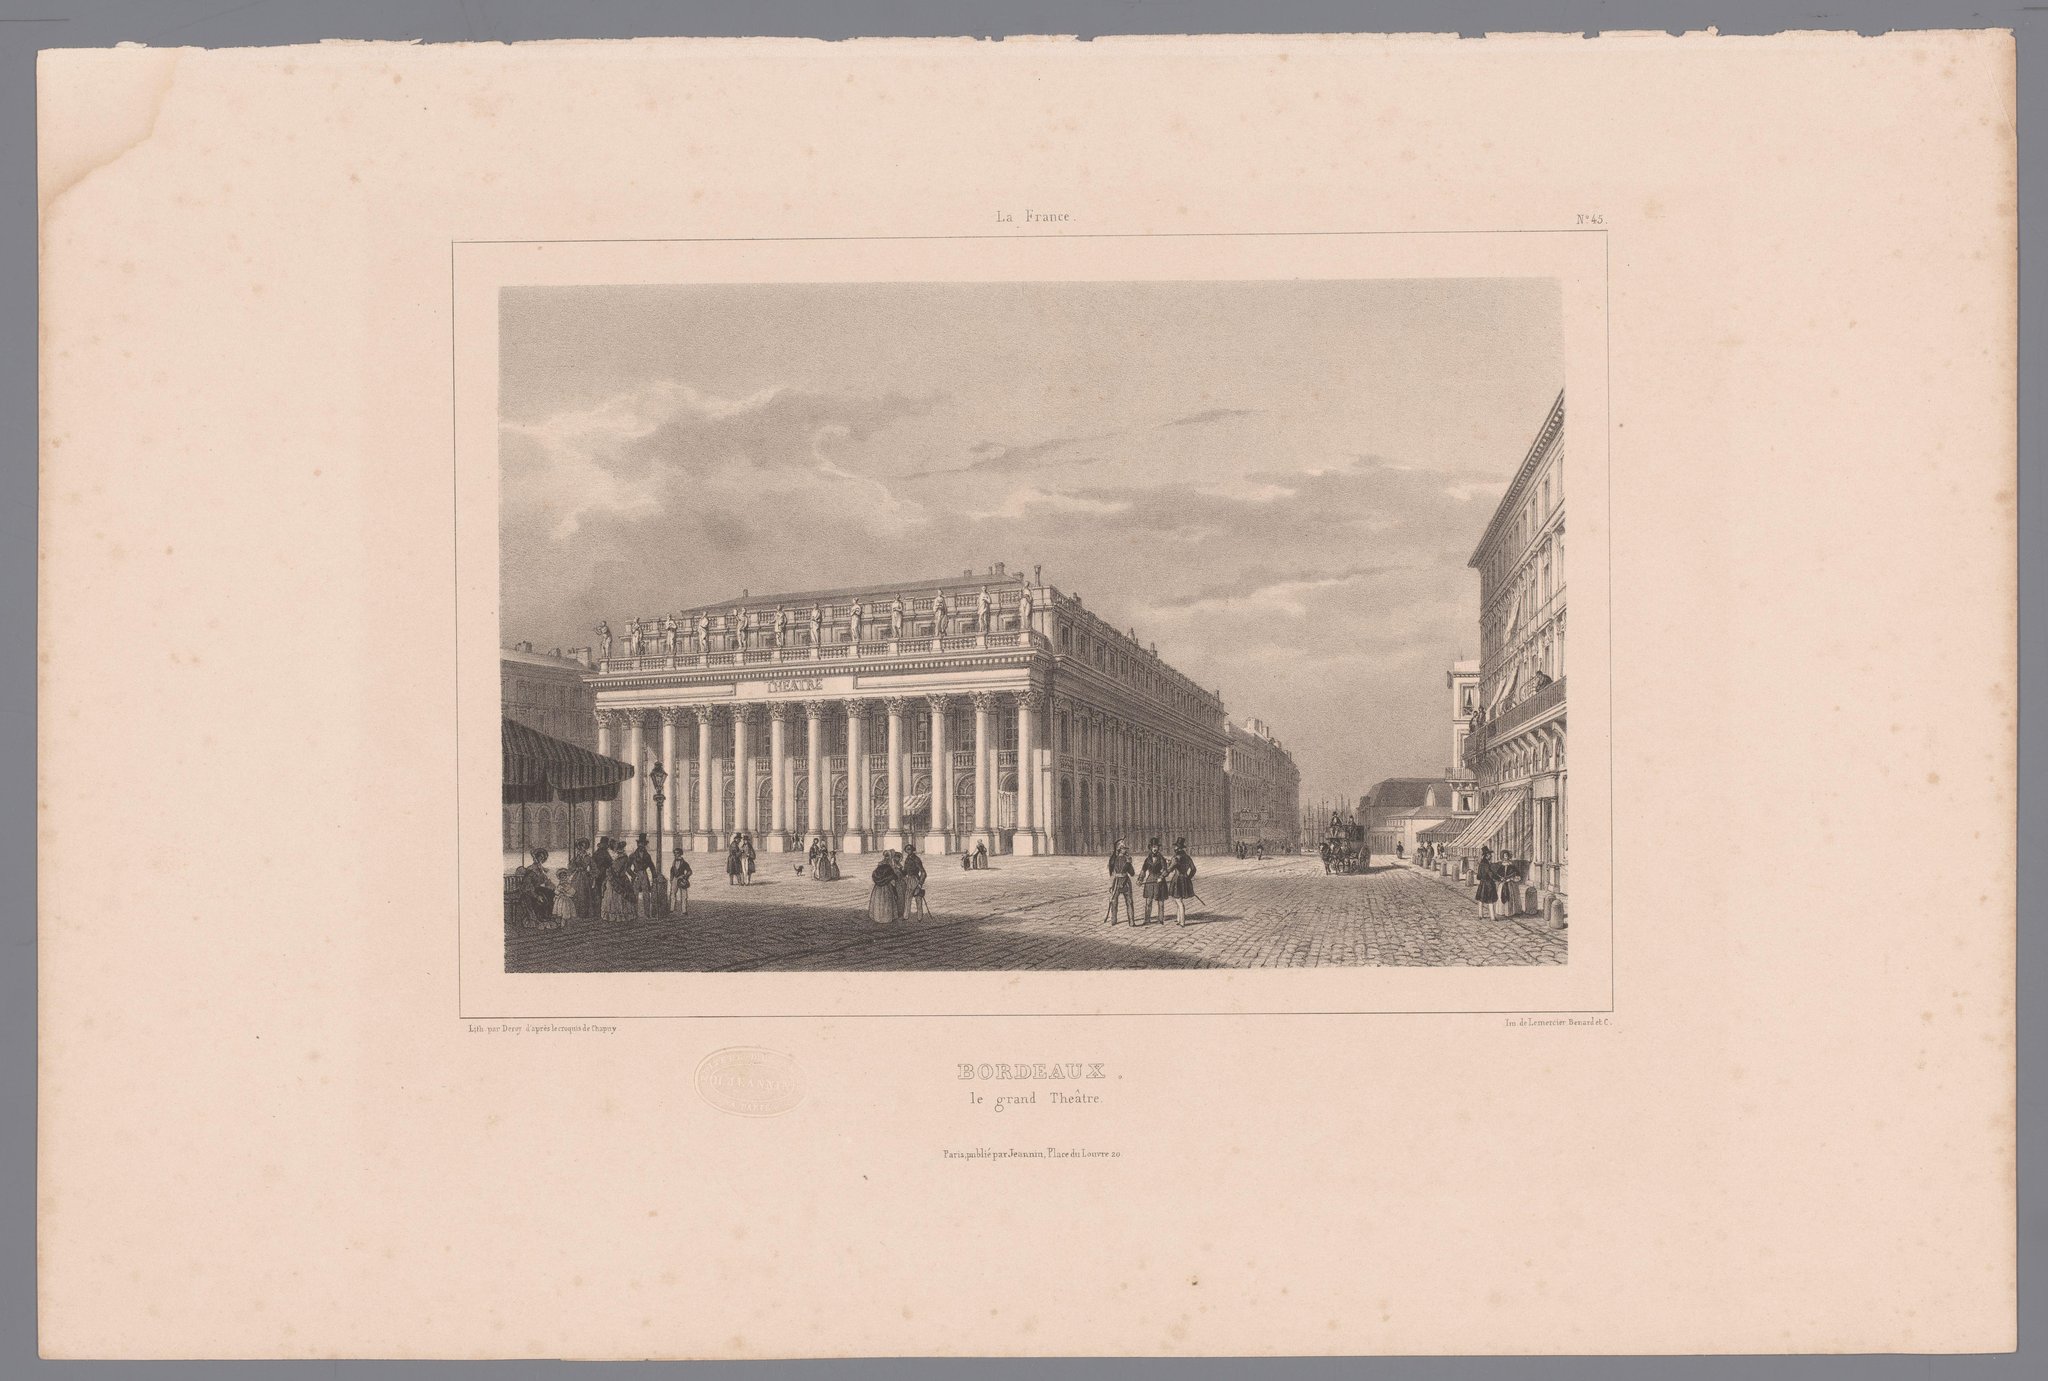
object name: print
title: La France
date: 1834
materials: paper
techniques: lithograph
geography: paris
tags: theatre (building)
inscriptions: check stamp: Lugt 1397c, collector's mark: Lugt 2228a